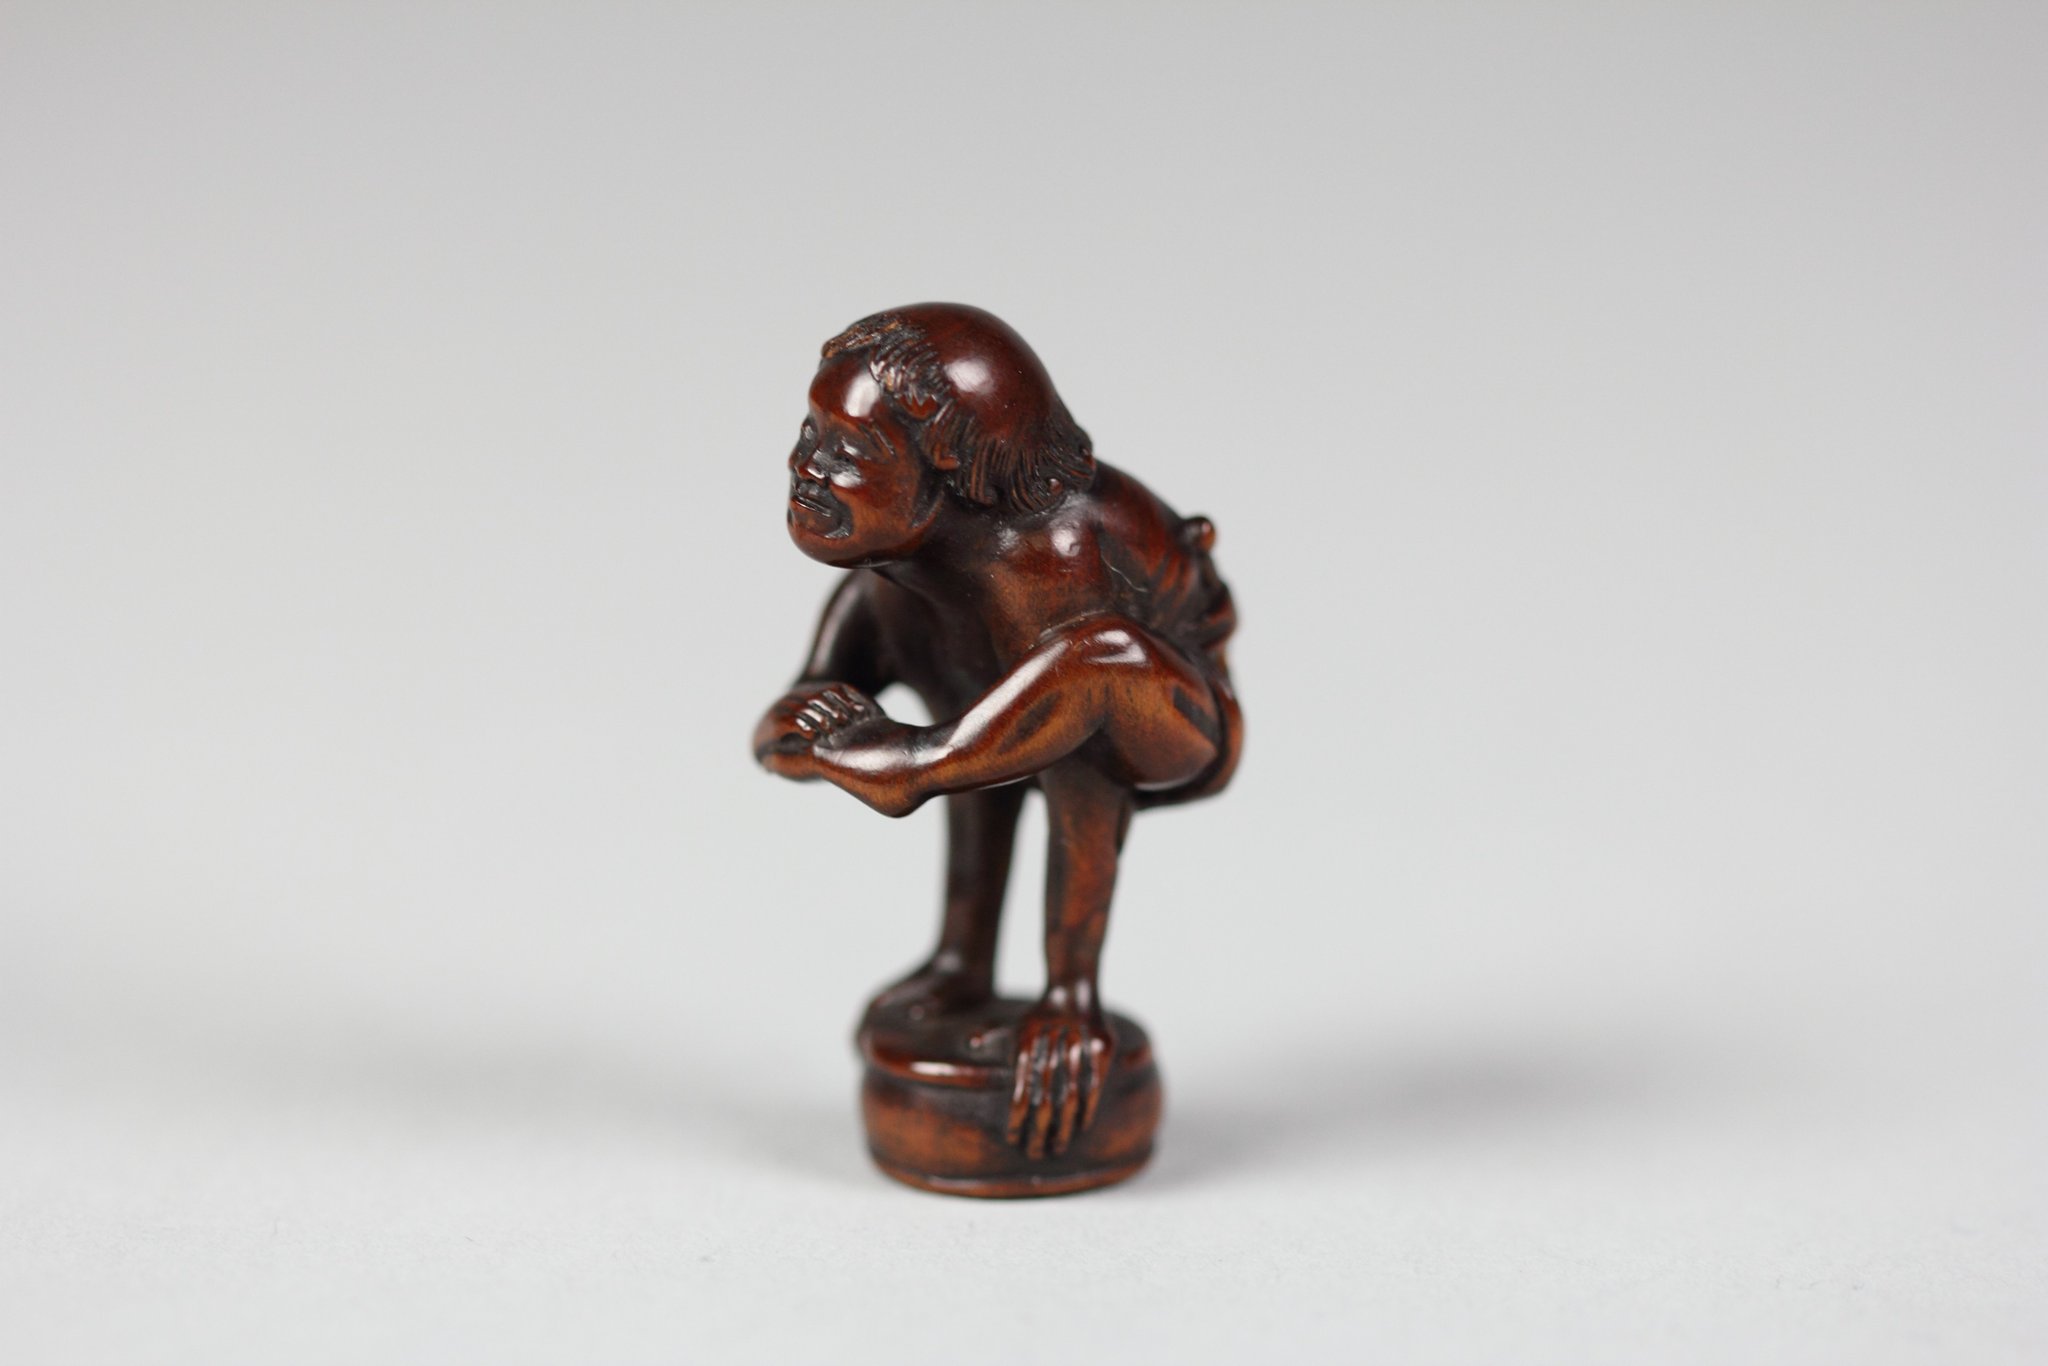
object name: netsuke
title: Netsuke of Acrobat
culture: japanese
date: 1801-1900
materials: wood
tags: acrobats